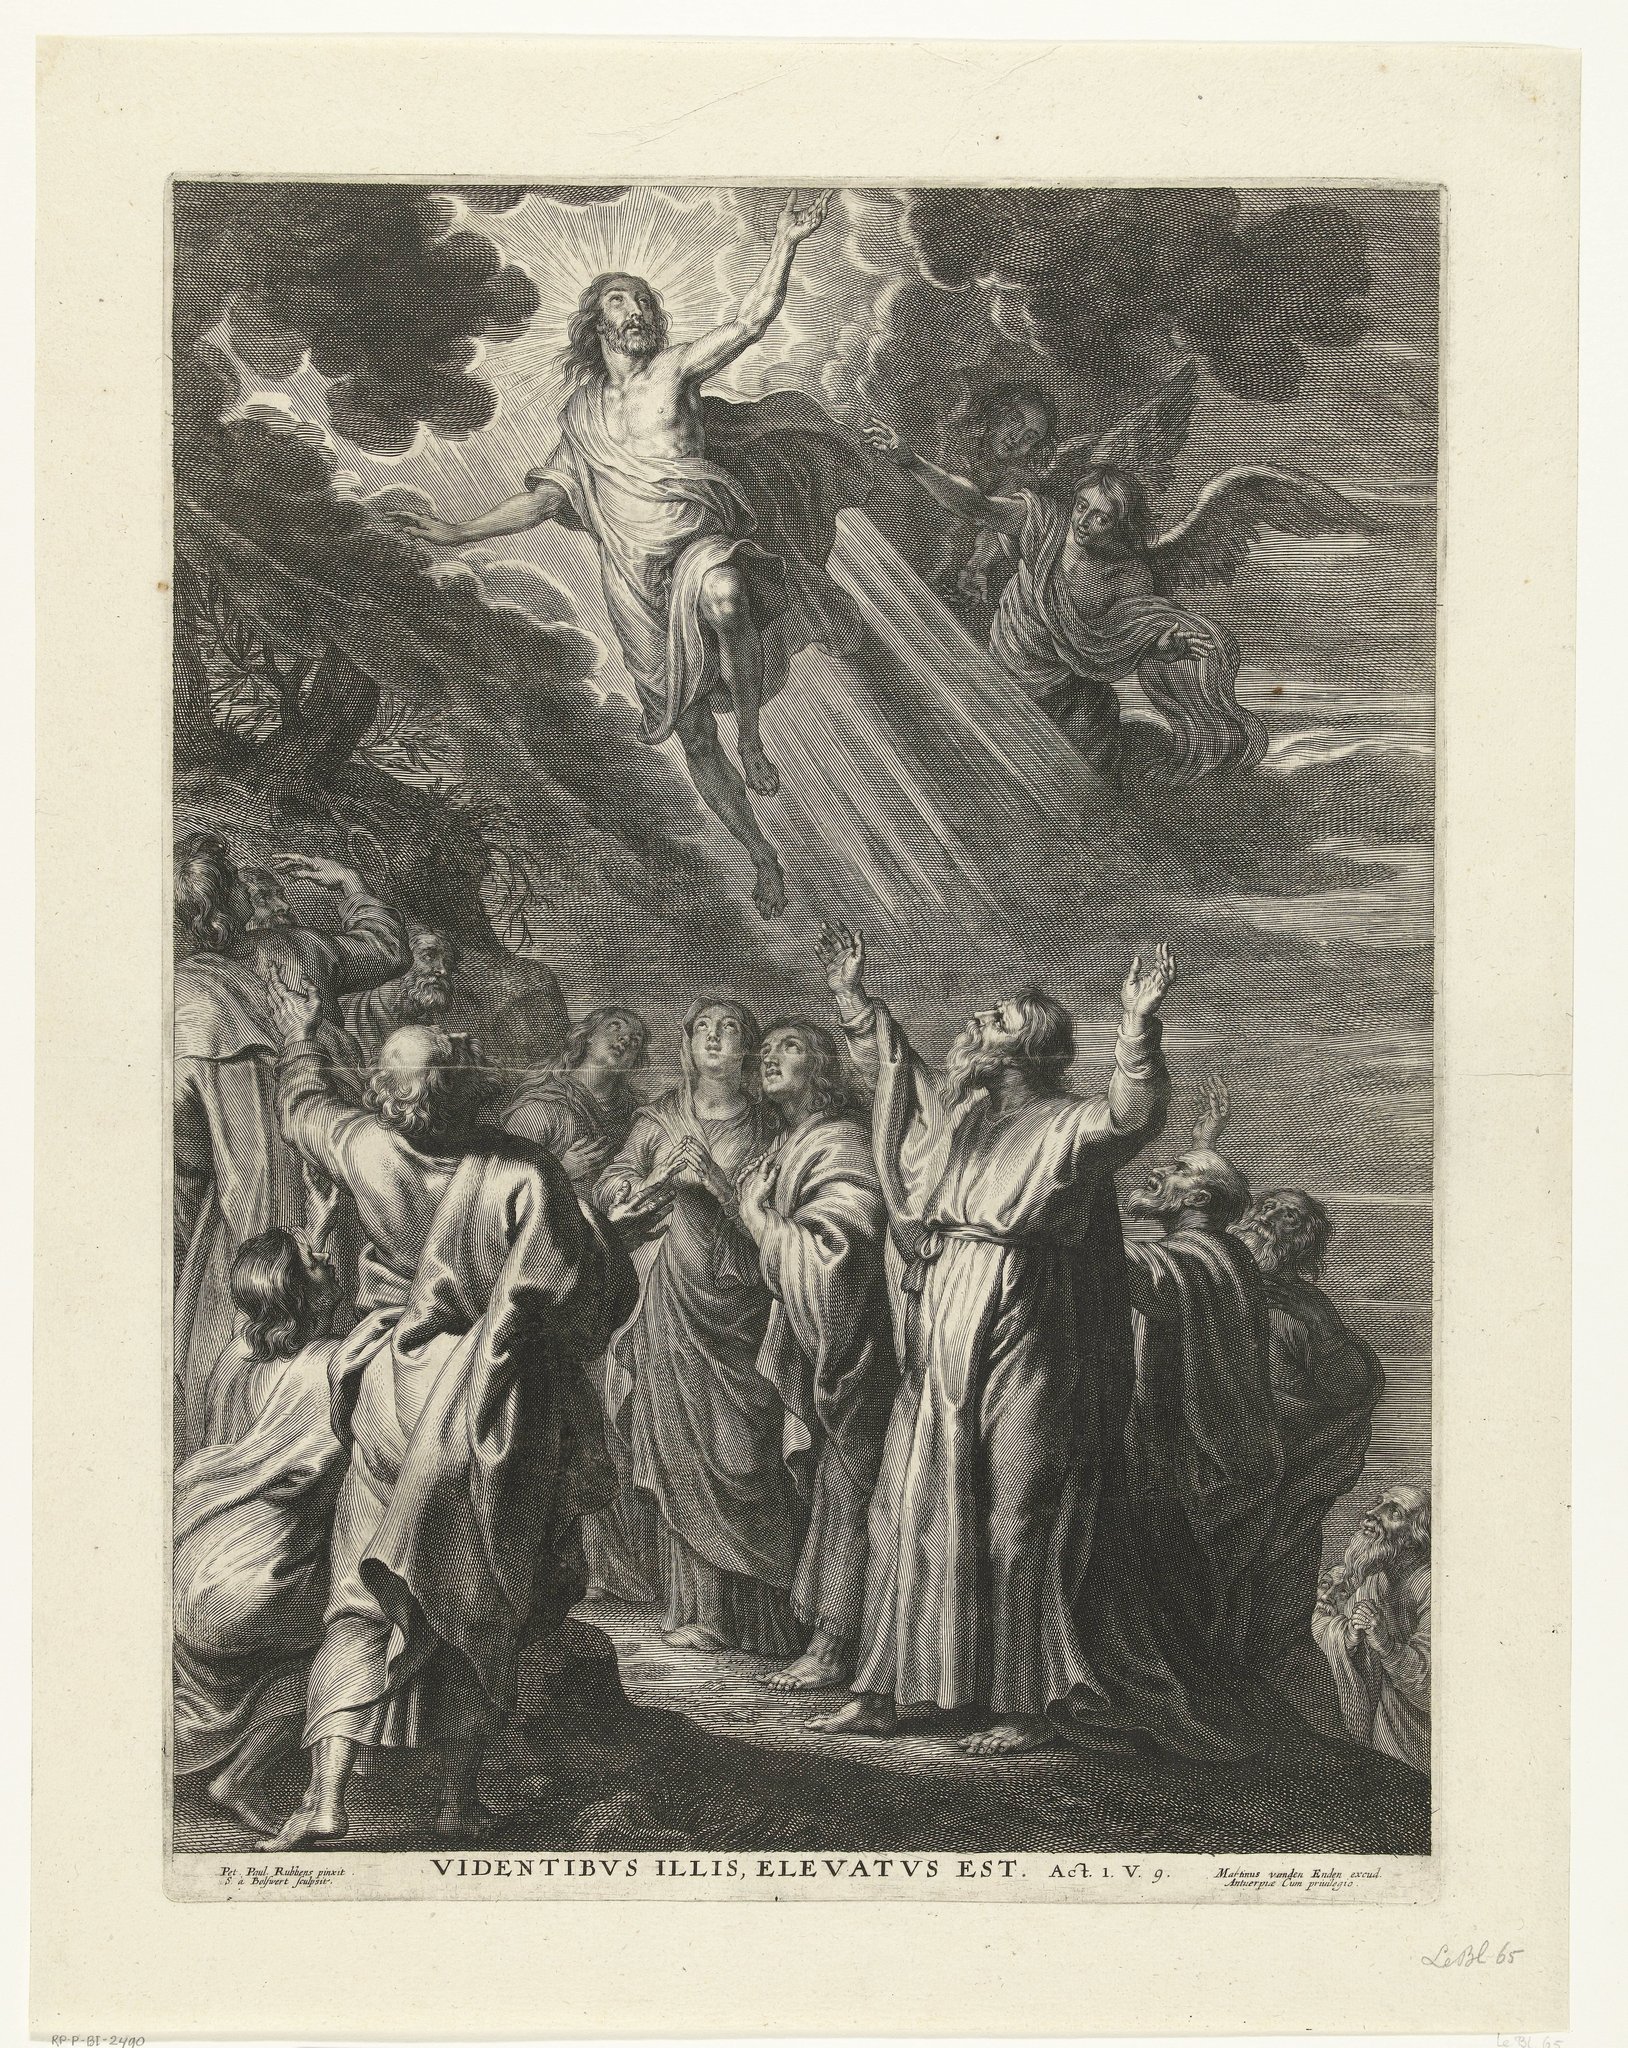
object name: print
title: Hemelvaart van Christus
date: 1596-1659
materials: paper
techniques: engraving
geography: antwerp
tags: christ ascends into heaven; apostles (and mary) beneath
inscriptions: collector's mark: Lugt 240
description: Hemelvaart van Christus in aanwezigheid van Maria en Johannes en de apostelen. Onder citaat uit Handelingen 1, vers 9.